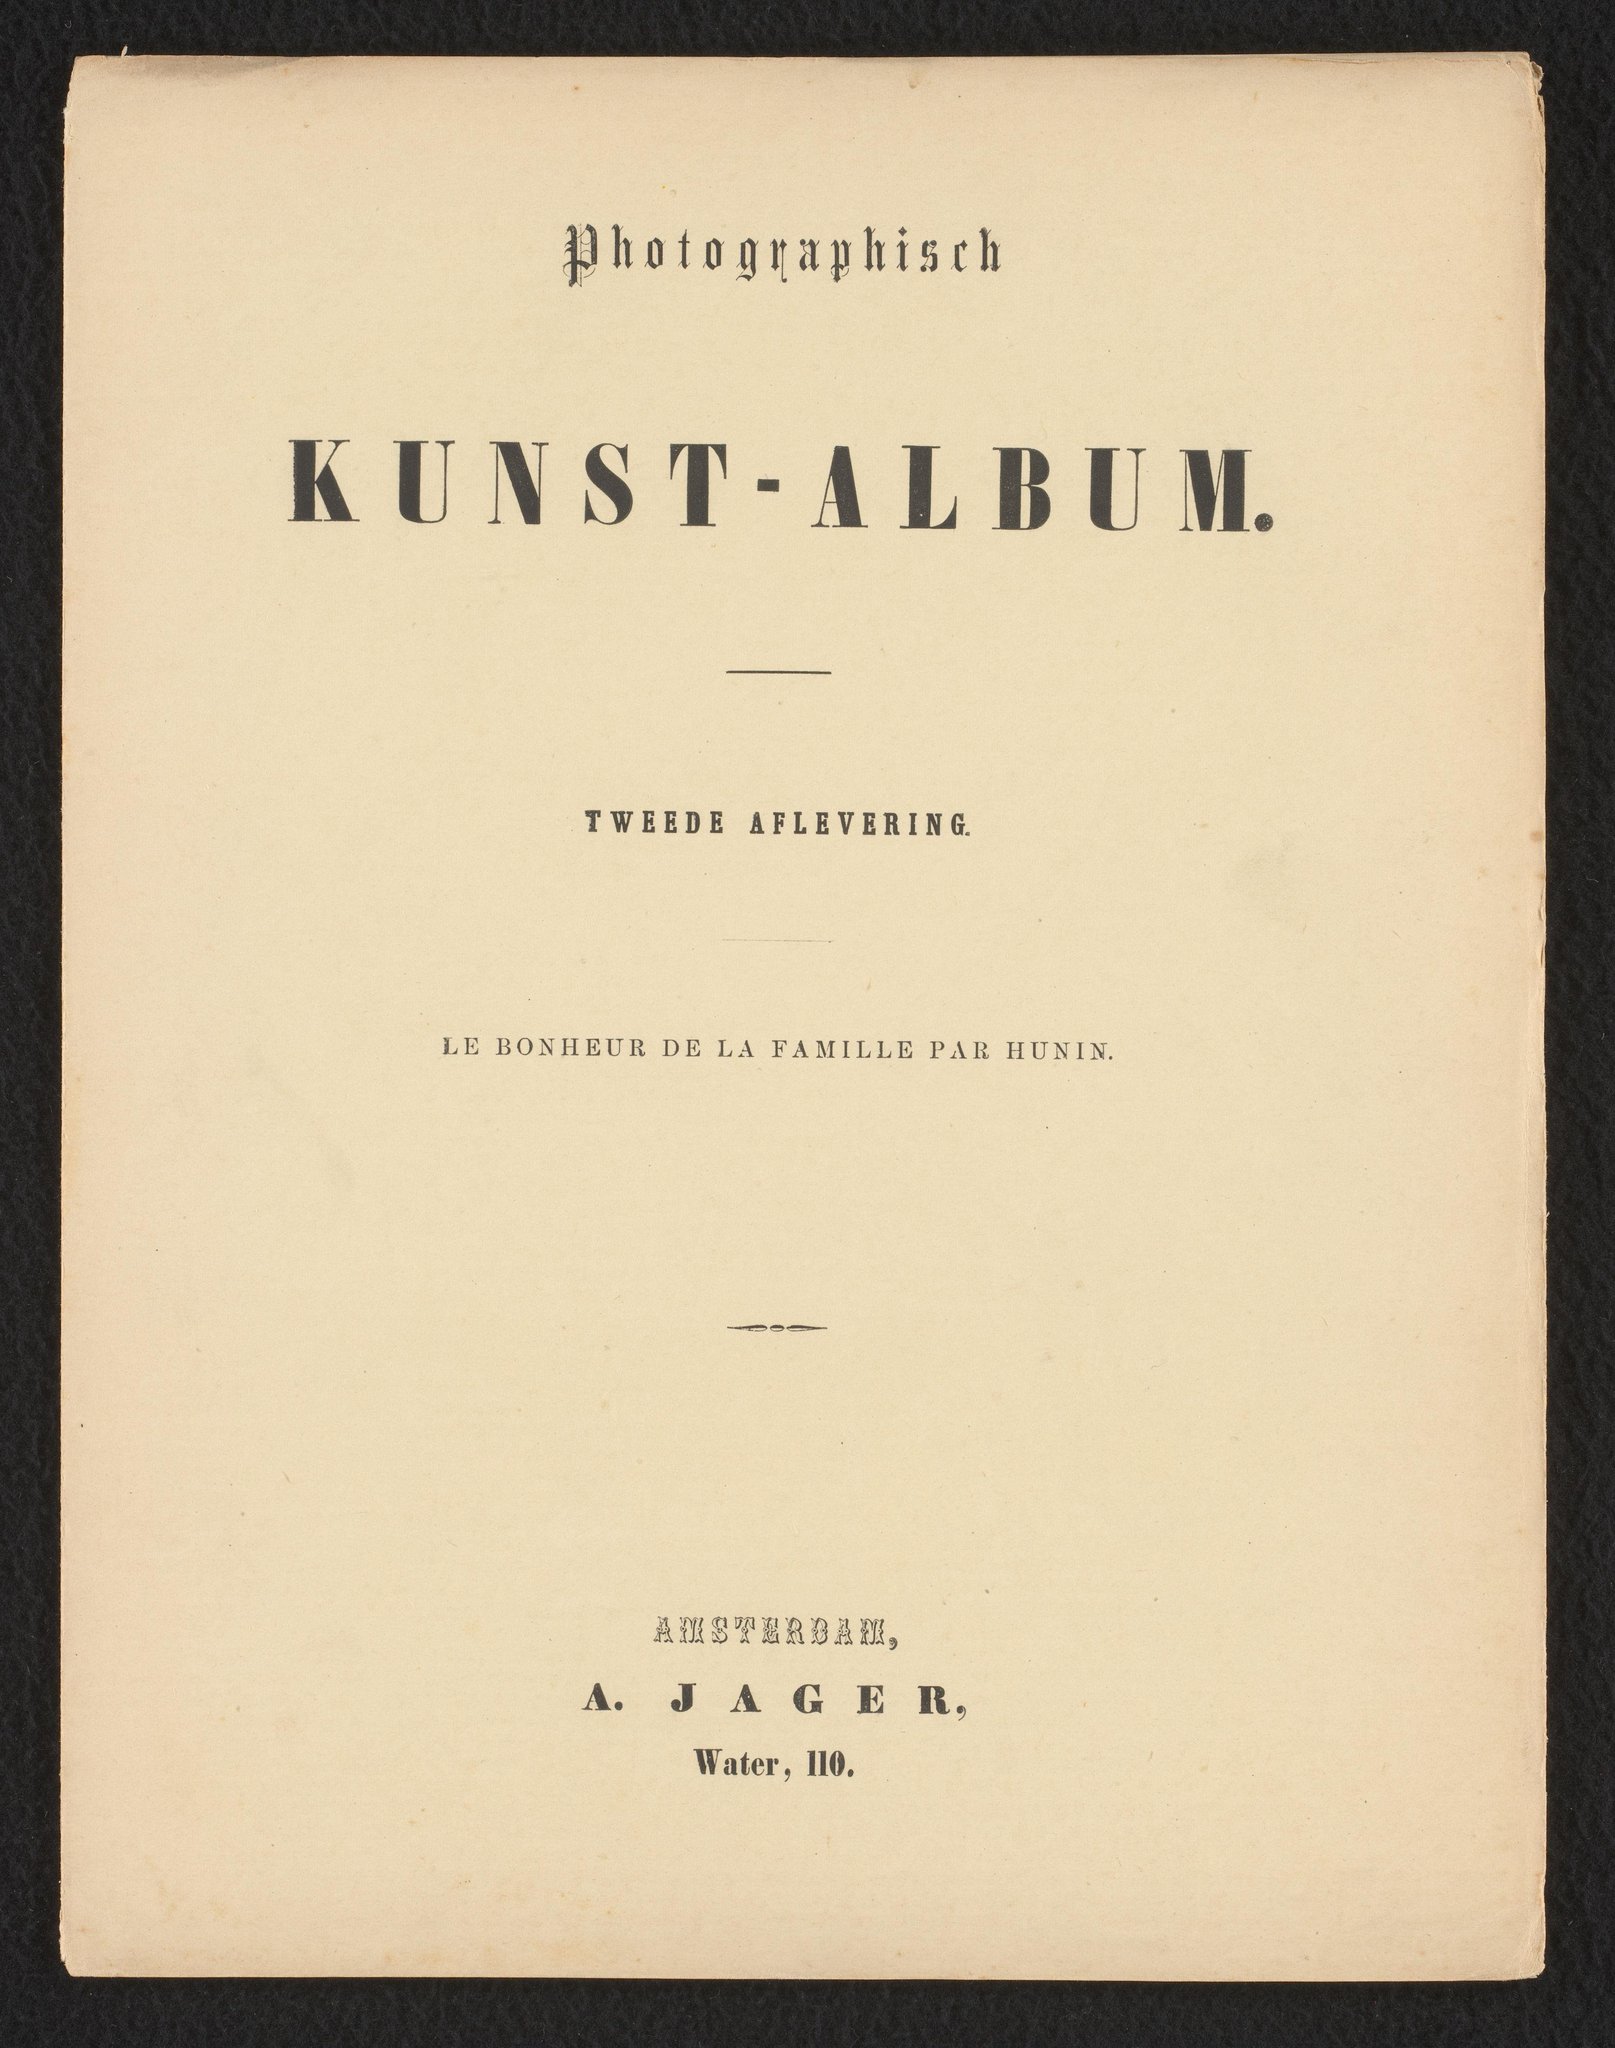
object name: wrapper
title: Photographisch Kunst-Album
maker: andries jager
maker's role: publisher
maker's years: 1825-1905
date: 1860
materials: paper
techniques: printing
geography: amsterdam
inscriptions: address: ‘AMSTERDAM,/ A. JAGER,/ Water, 110.’, inscription: ‘LE BONHEUR DE LA FAMILLE/ NAAR EENE SCHILDERIJ/ VAN/ HUNIN.’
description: Deze omslag maakt deel uit van een omslag met twaalf fotoreproducties.